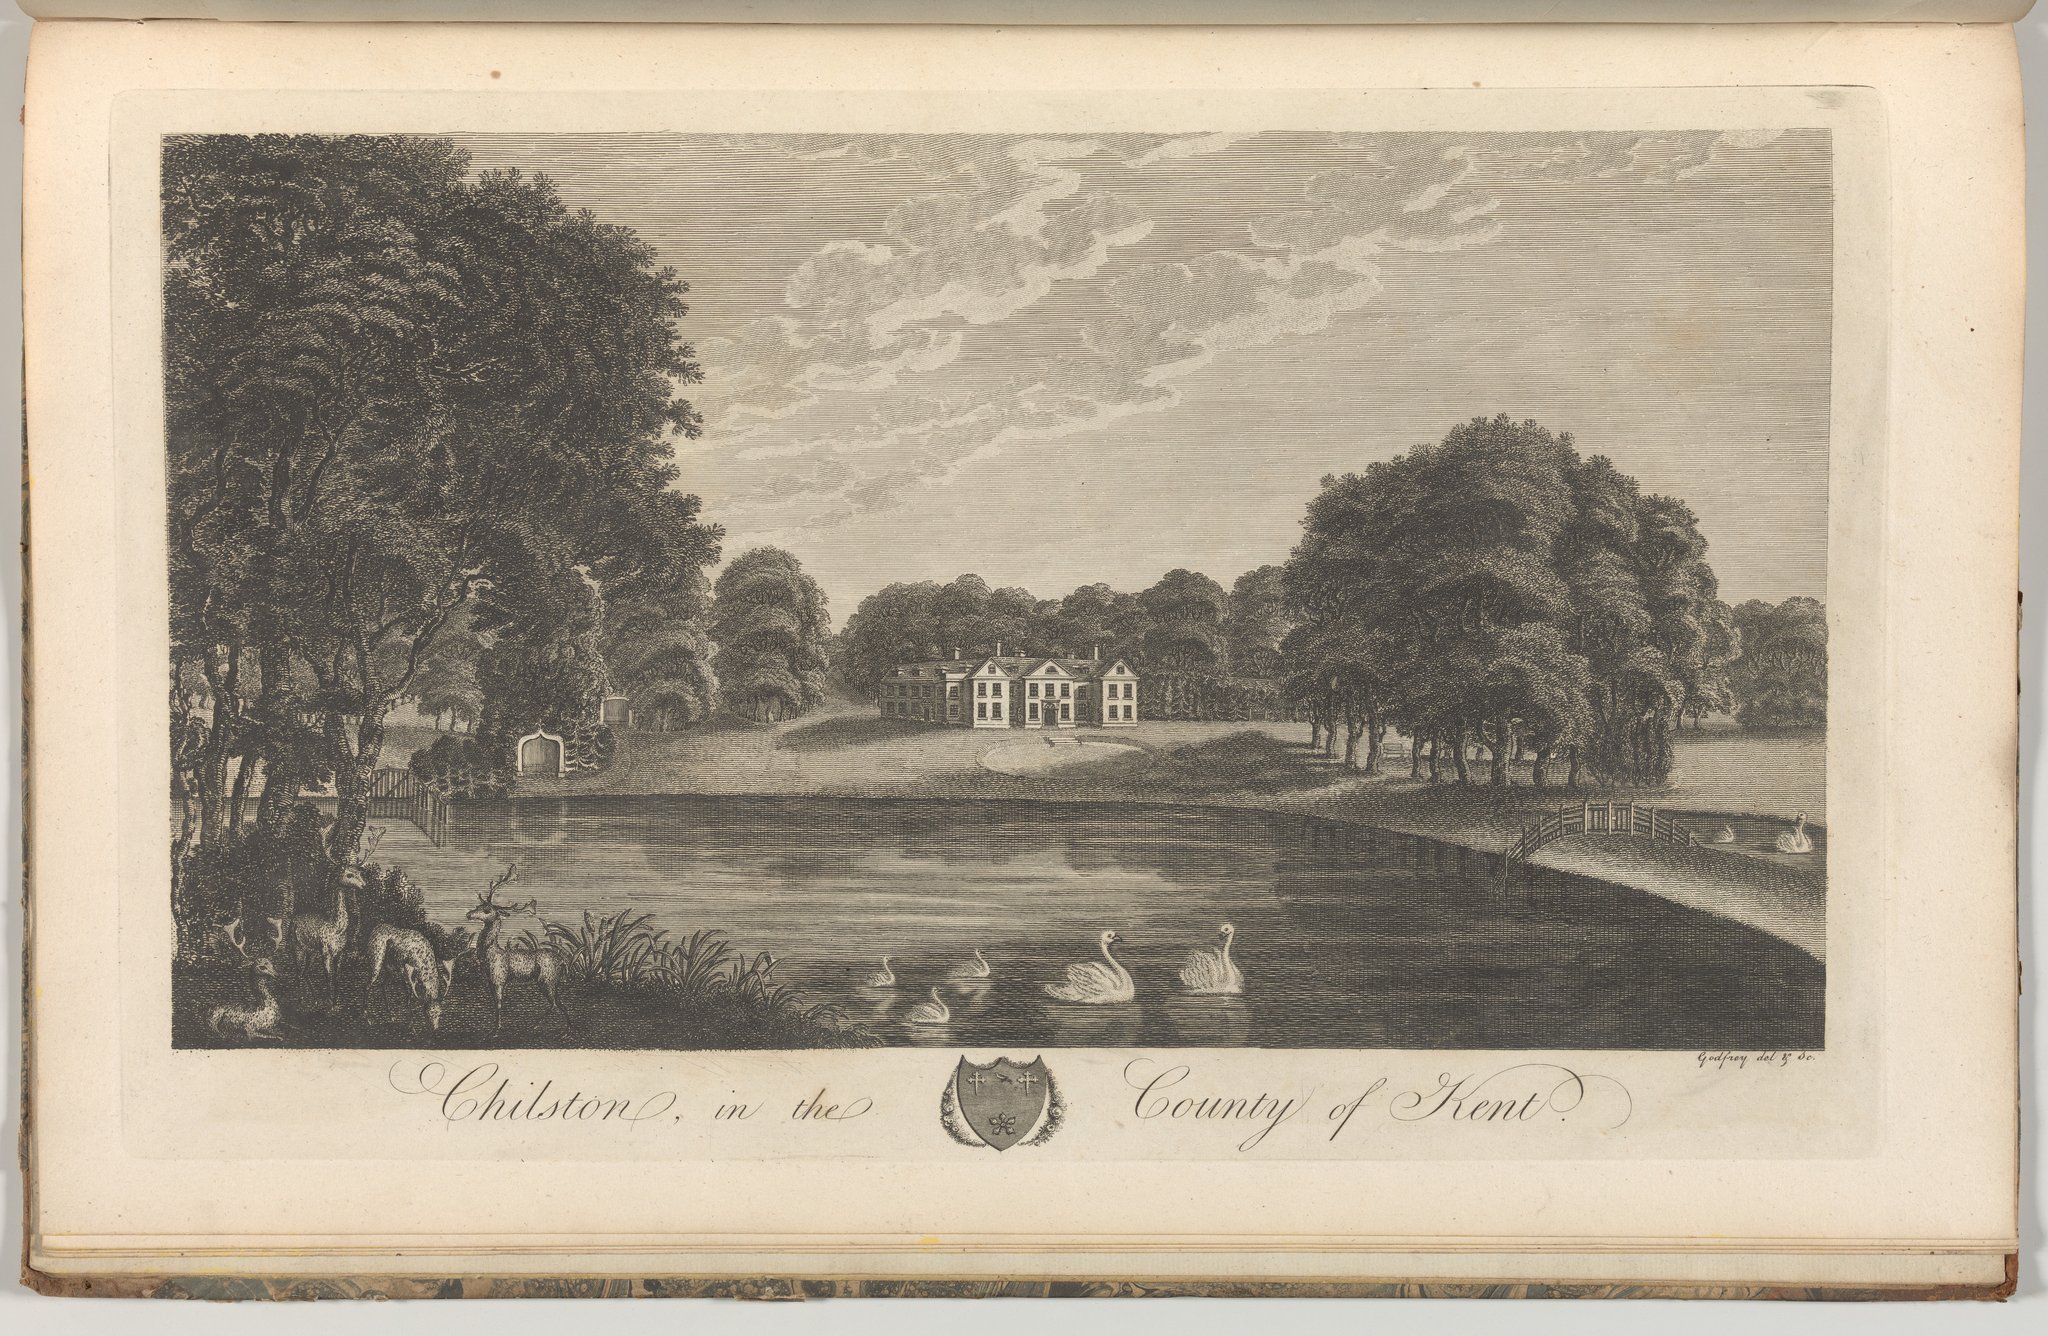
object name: print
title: Somerhill, near Tunbridge, in the County of Kent, from Edward Hasted's "The History and Topographical Survey of the County of Kent", vols. 1-3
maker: richard bernard godfrey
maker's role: artist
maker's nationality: british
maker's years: 1728-1795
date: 1777-1790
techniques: engraving, etching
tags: buildings,swans,lakes,landscapes,trees